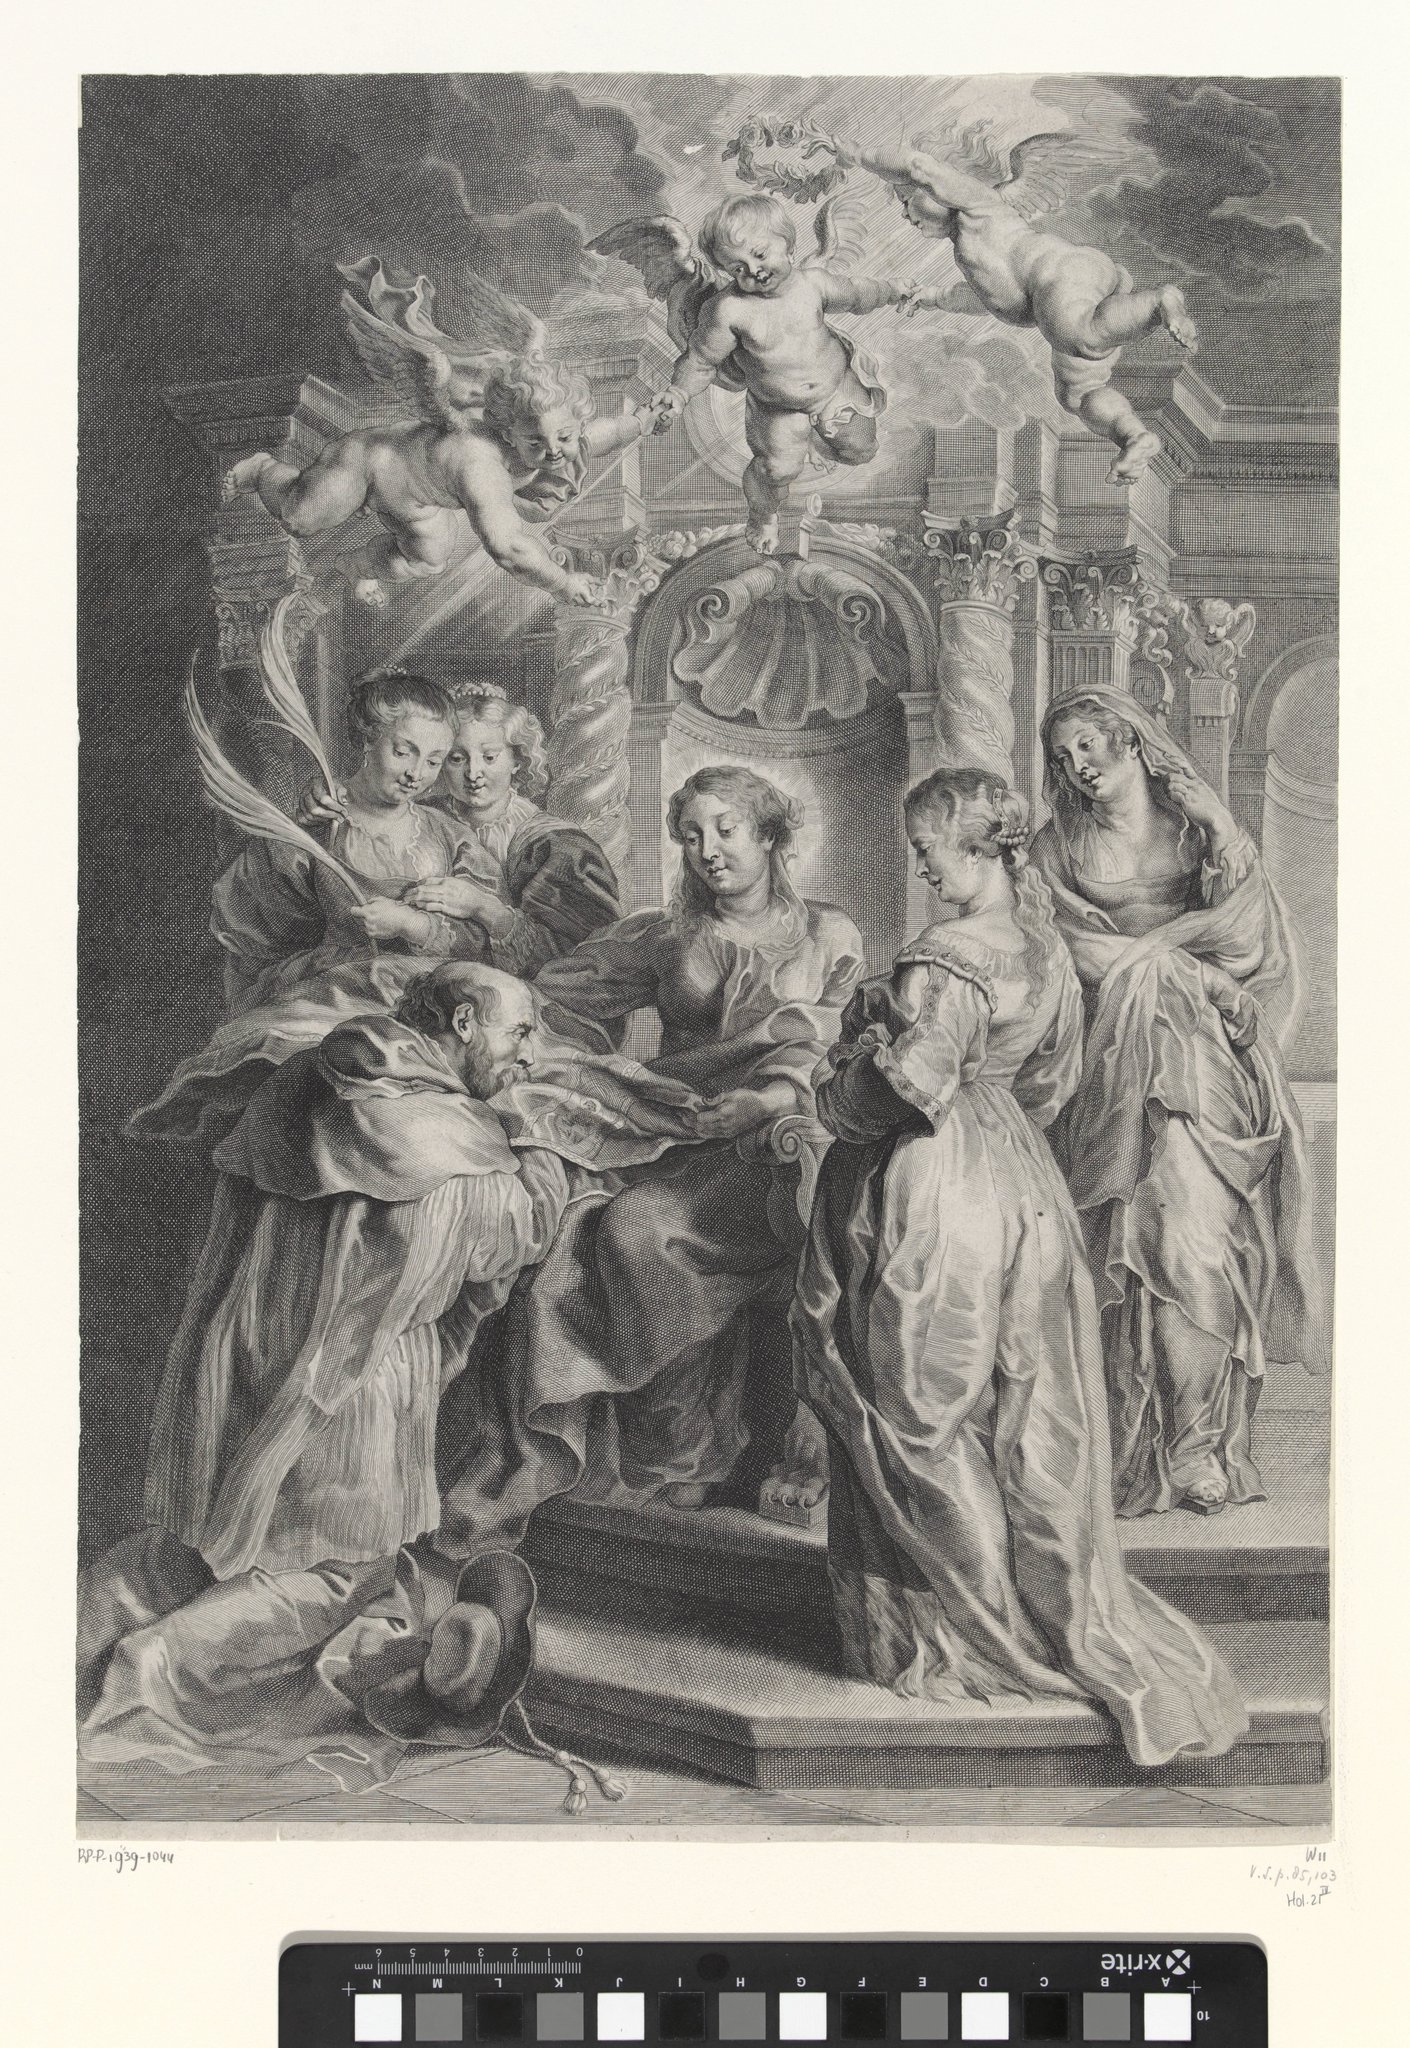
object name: print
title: Visioen van de H. Ildephonsus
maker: hans witdoeck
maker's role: print maker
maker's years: 1615-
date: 1638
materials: paper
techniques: engraving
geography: antwerp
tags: the virgin mary appears to st. ildefonso and gives him a chasuble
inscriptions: collector's mark: Lugt 2228, number: ‘42’, collector's mark: Lugt 778, collector's mark: Lugt 429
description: In de kathedraal van Toledo wordt de heilige Ildephonsus door Maria bekleedt met een kazuifel. Vier vrouwen kijken toe, ze staan aan weerszijden van Maria's troon. Boven hen engelen, van wie één een lauwerkrans in de hand houdt.